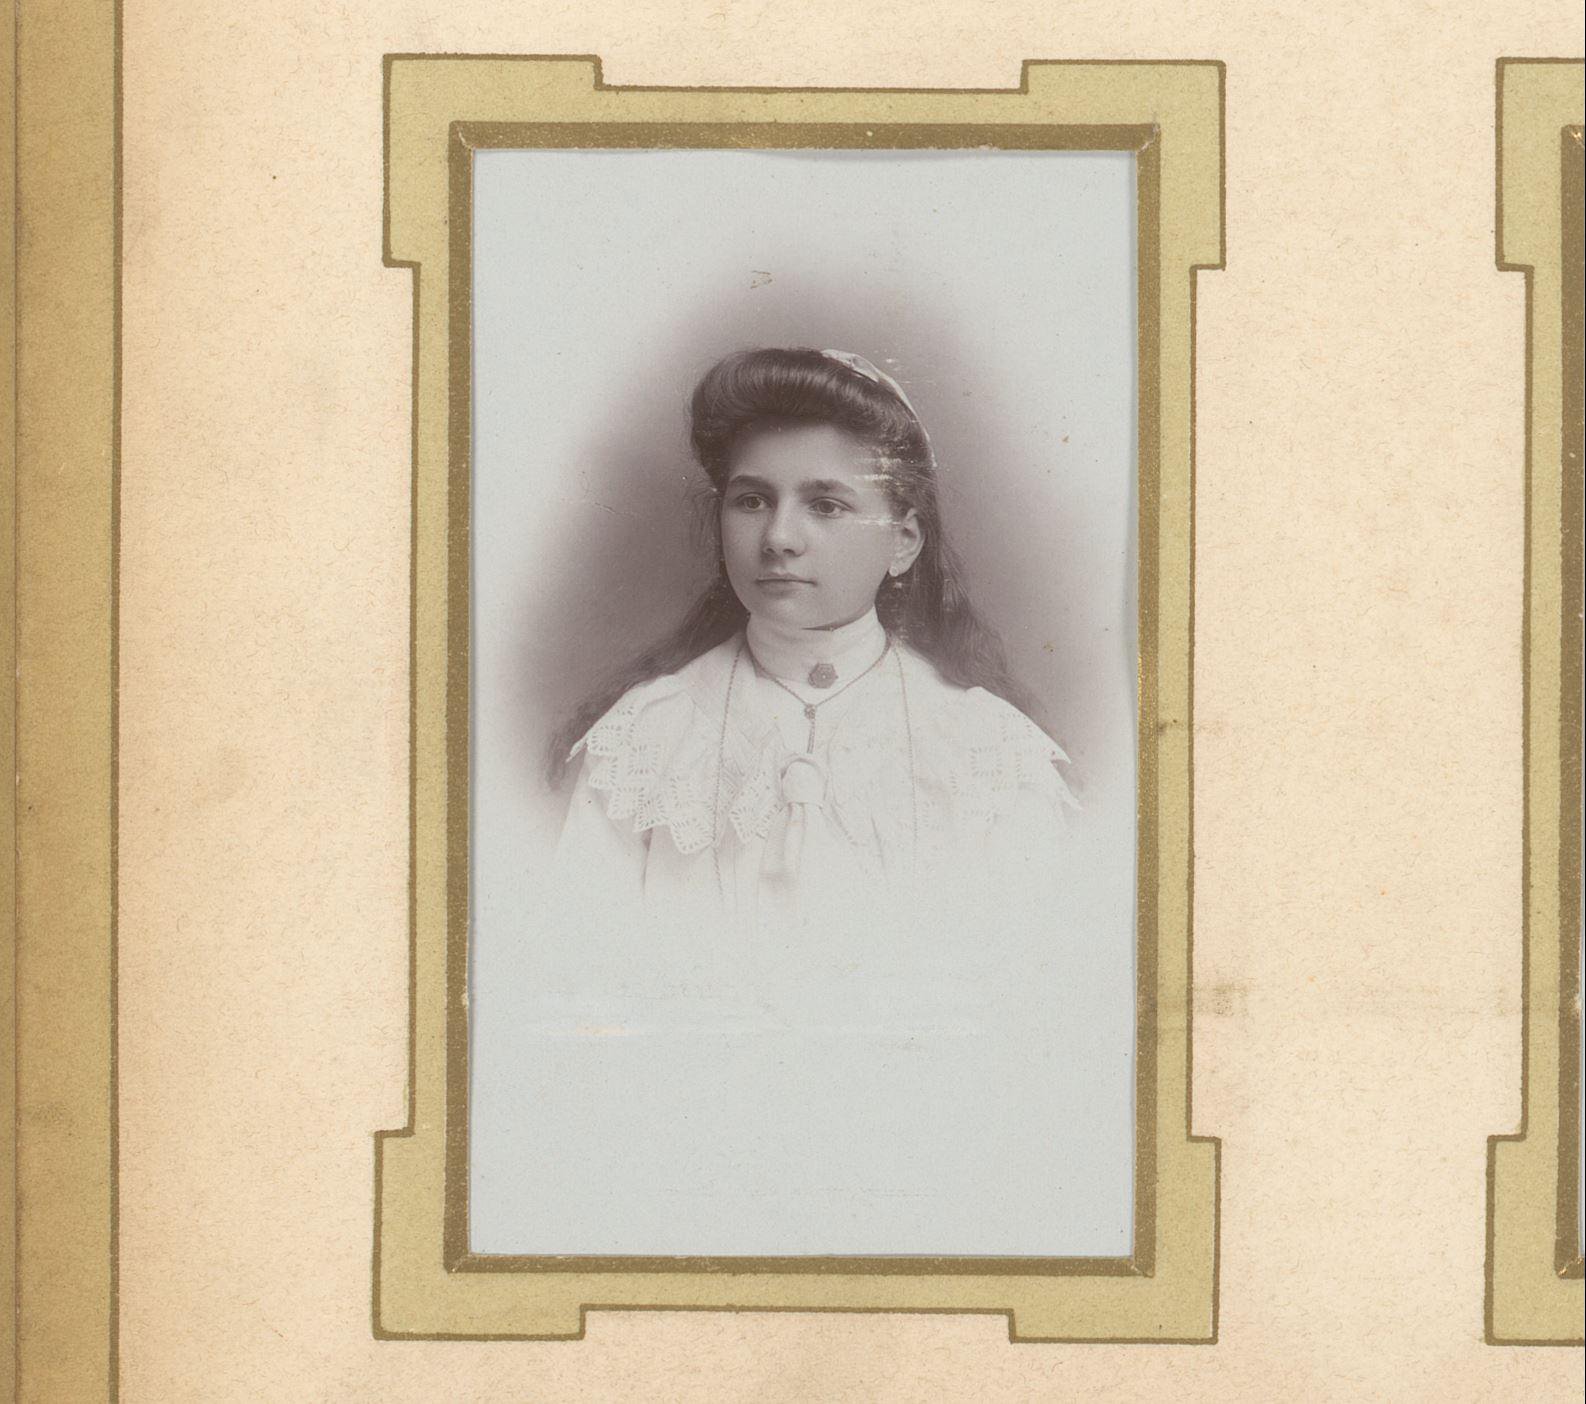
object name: album leaf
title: Portret van een meisje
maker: emile morren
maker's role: fotograaf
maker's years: 1865-1941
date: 1860-1900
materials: cardboard, photographic support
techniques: collodion silver print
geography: leuven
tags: girl (child between toddler and youth)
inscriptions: inscription: ‘Emile Morren (...) 18 Rue de Namur/ Louvain’